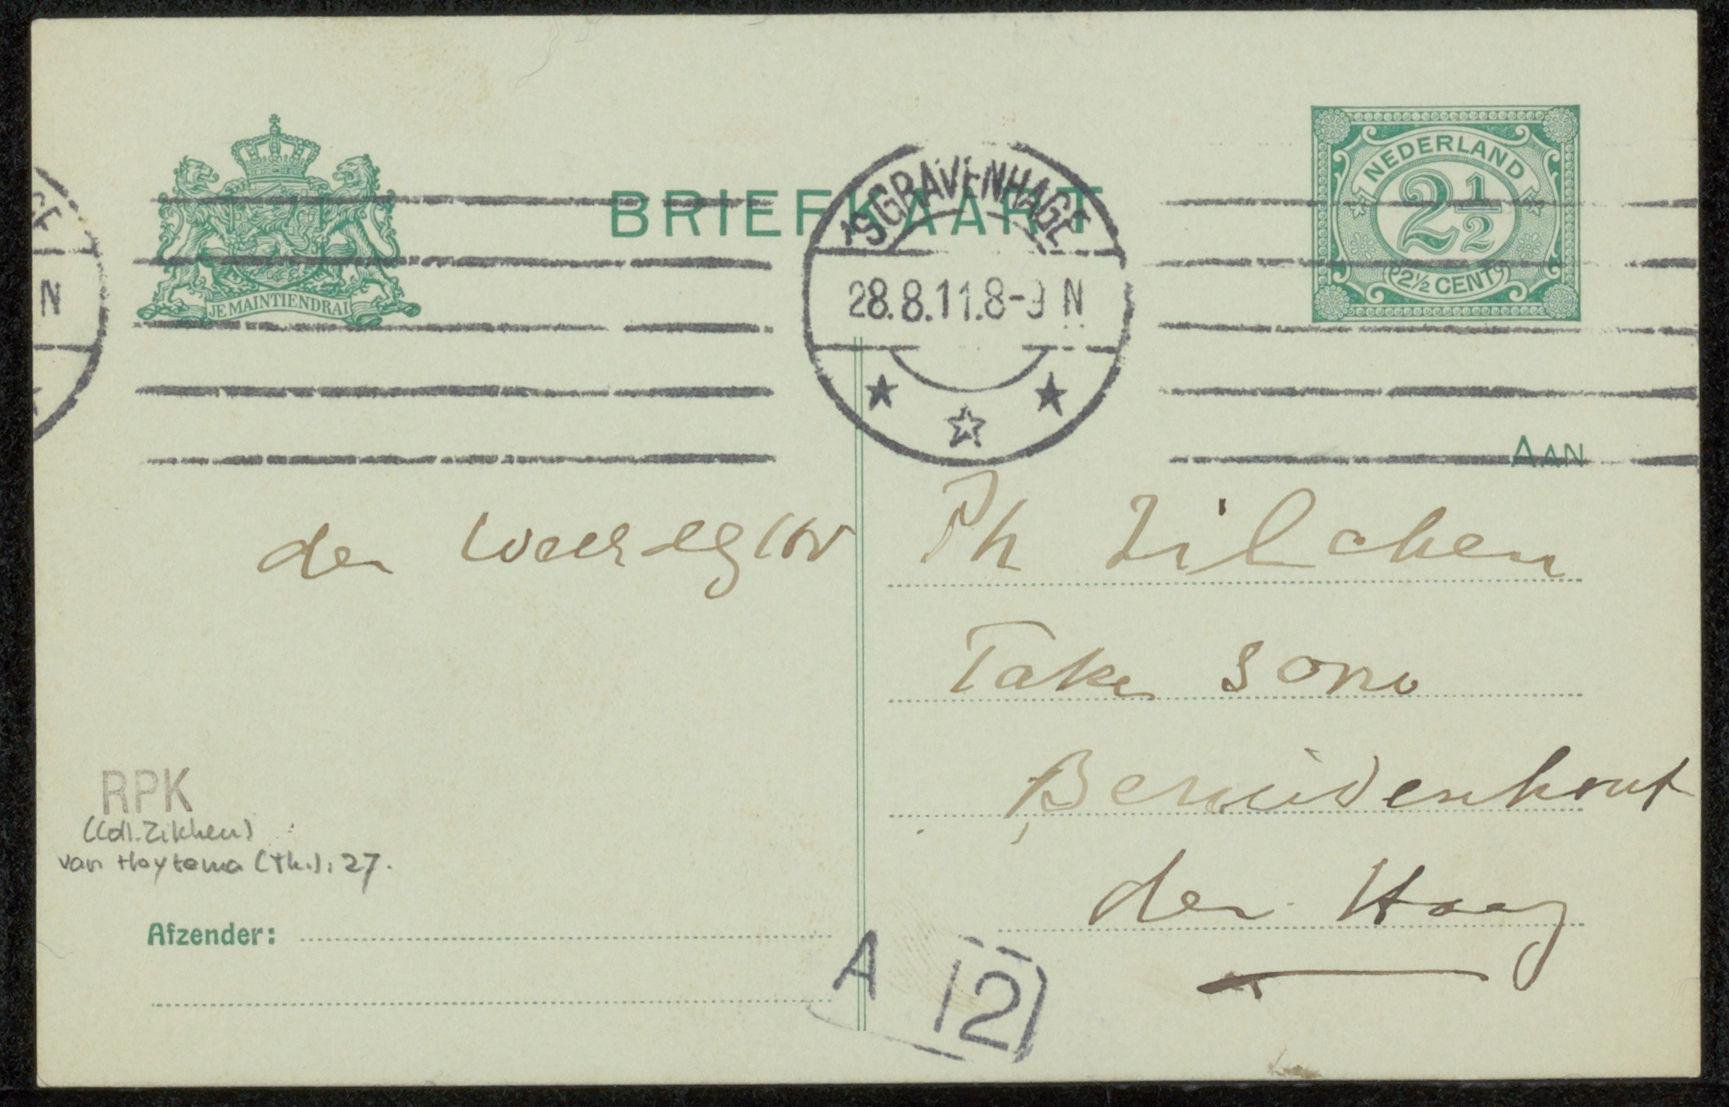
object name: postcard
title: Briefkaart aan Philip Zilcken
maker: theo van hoytema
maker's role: draughtsman, painter, print maker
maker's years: 1863-1917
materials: cardboard, ink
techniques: pen, writing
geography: the hague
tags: philip zilcken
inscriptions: collector's mark: ‘RPK’